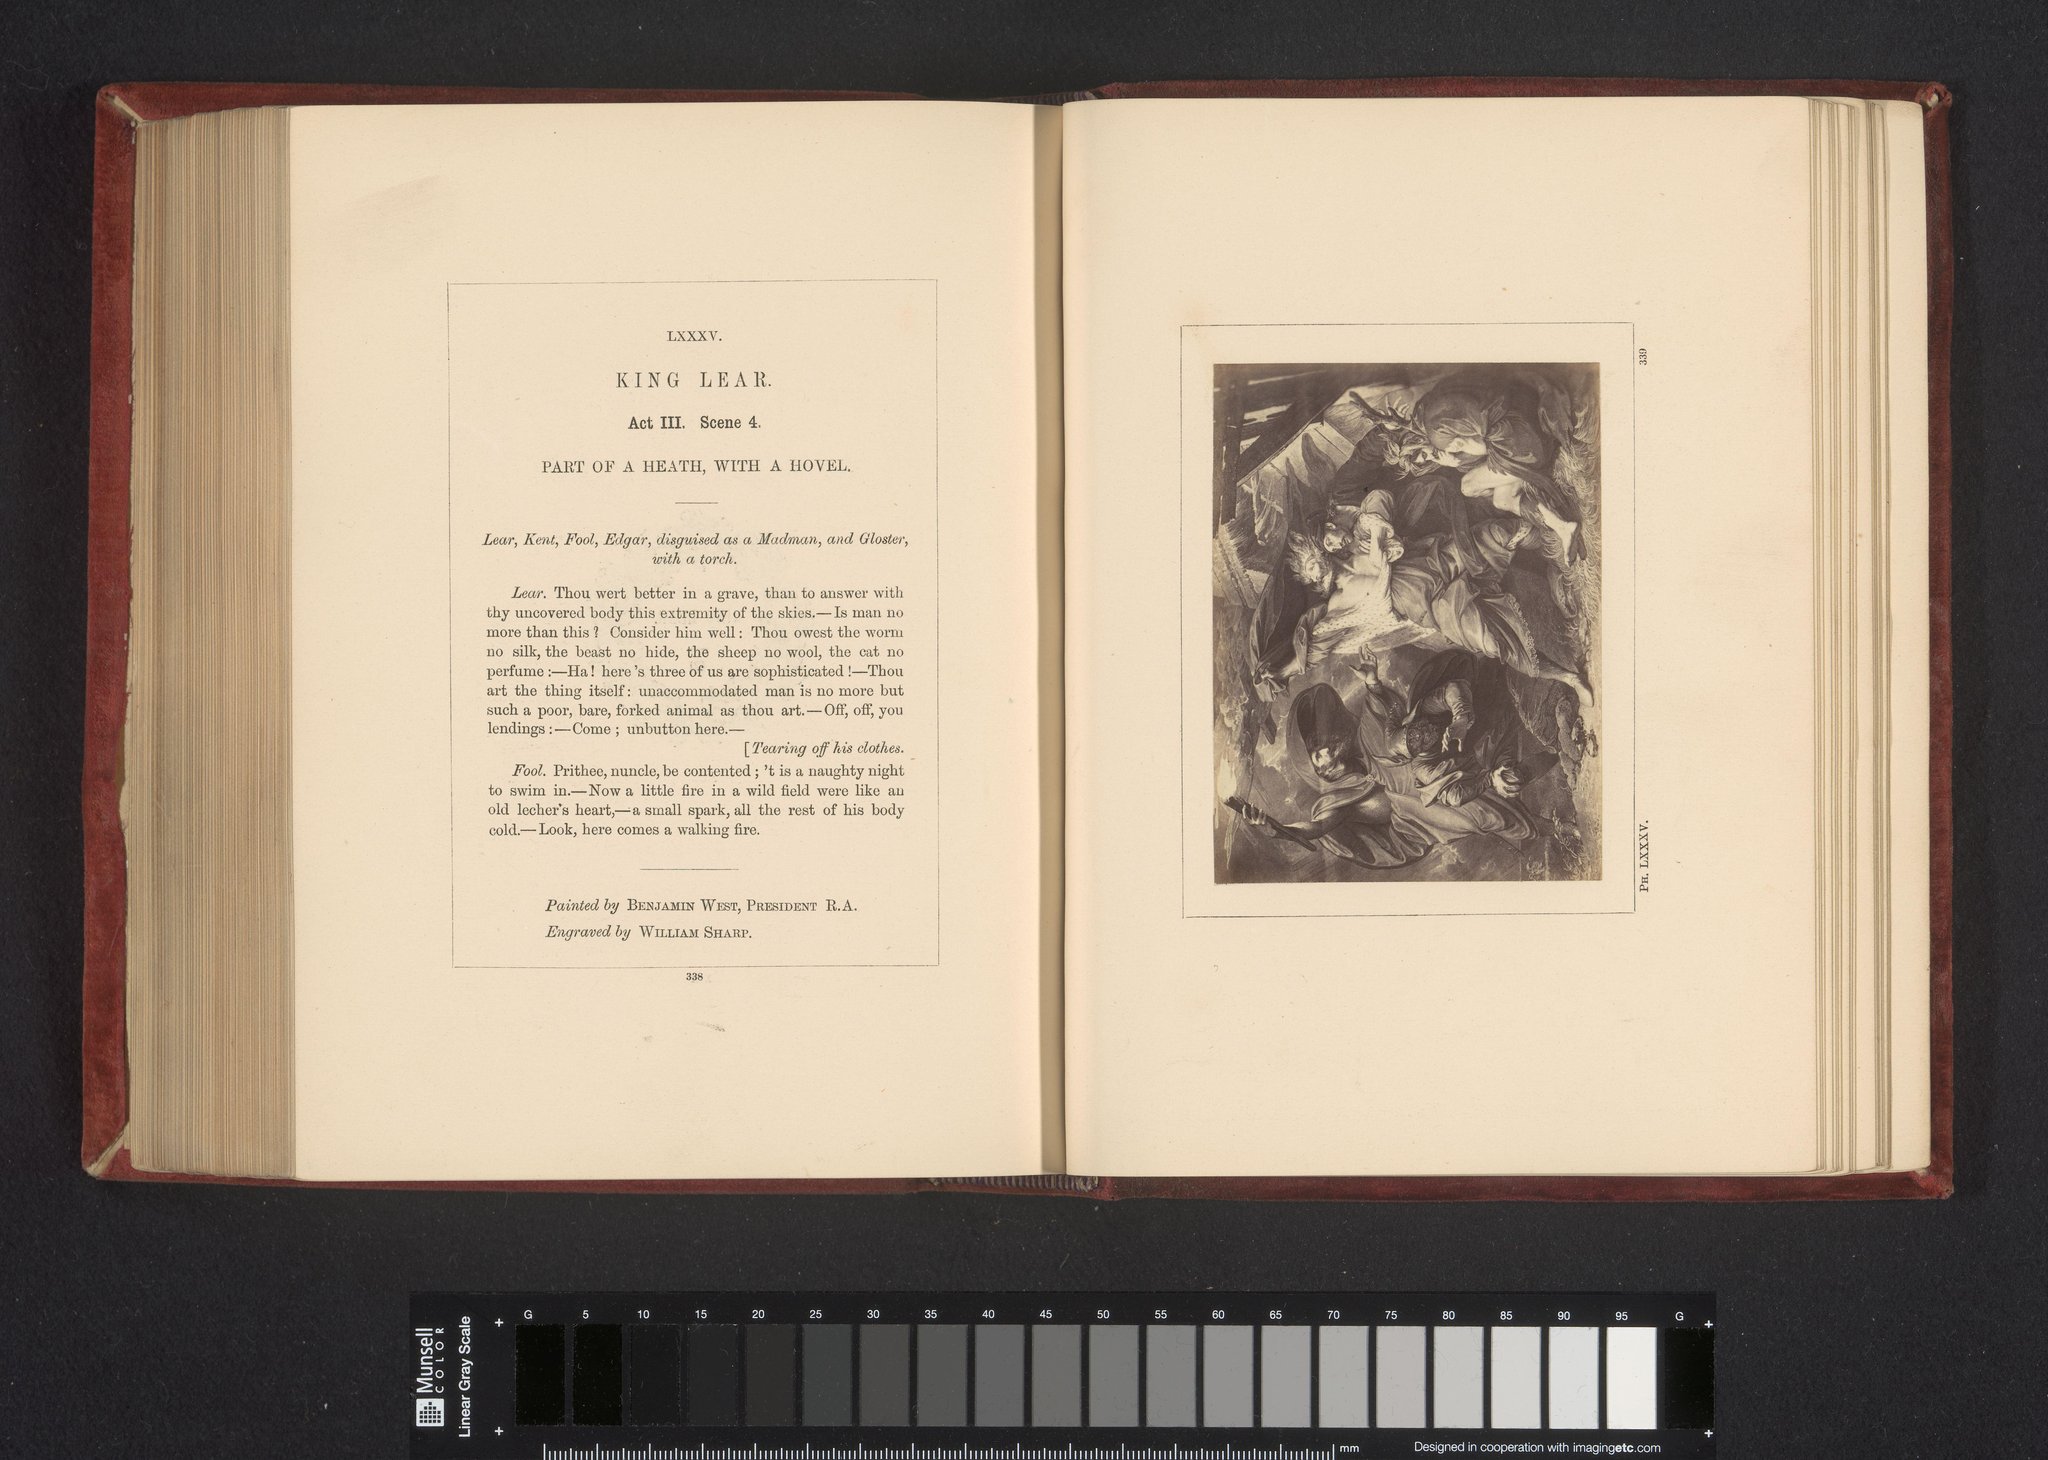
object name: photograph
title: Fotoreproductie van een prent naar een schilderij door Benjamin West, voorstellend een scene uit Koning Lear door William Shakespeare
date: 1854-1864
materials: photographic support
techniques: albumen print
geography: london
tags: king lear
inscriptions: number: ‘Ph. LXXXV. 339’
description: Te zien is akte III, scene 4 met koning Lear en onder andere Edgar die is vermomd.